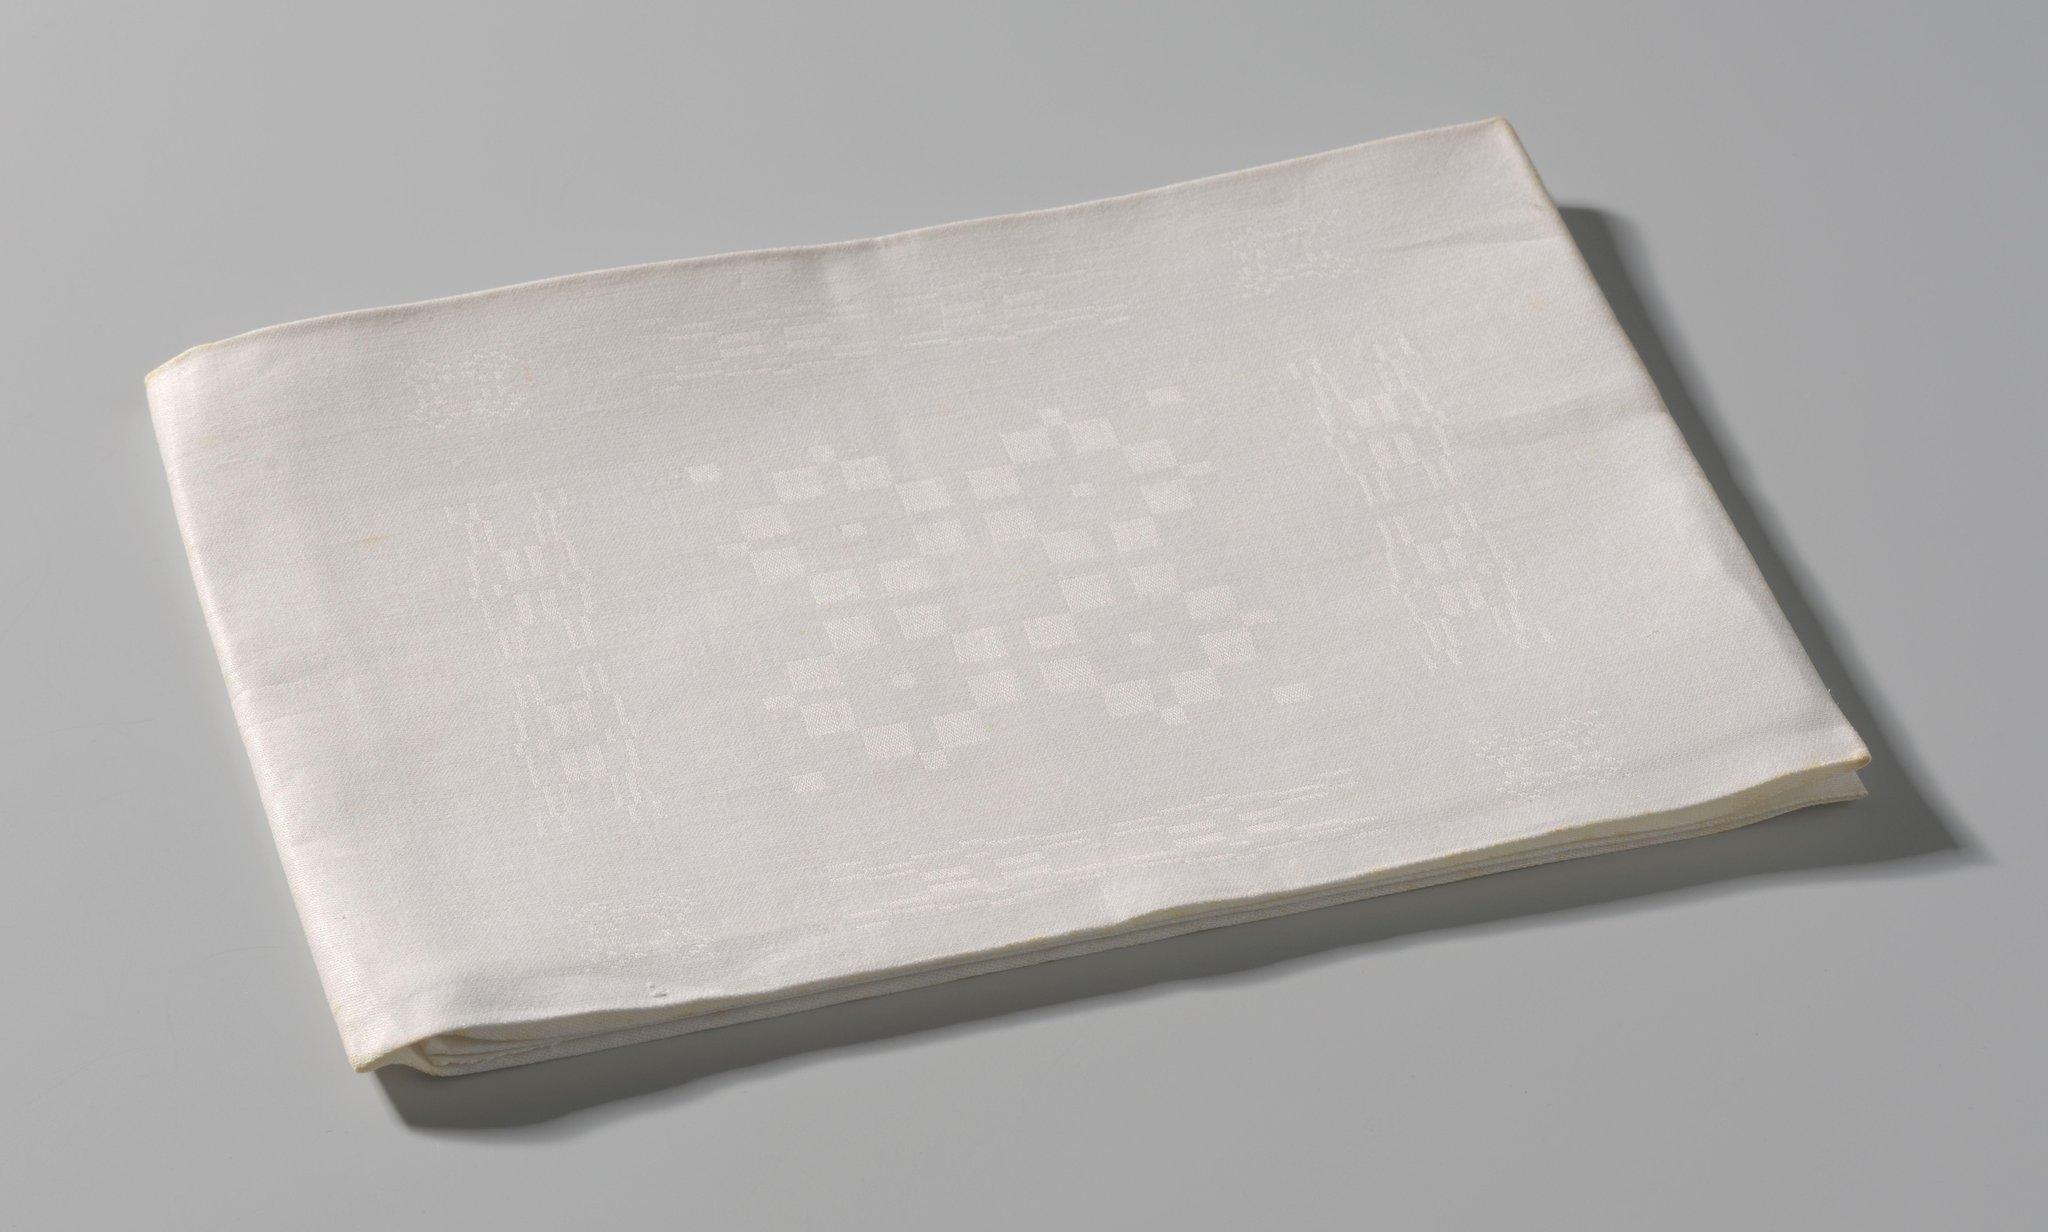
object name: napkin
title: Servet van pellendamast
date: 1800-1900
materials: linen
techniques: cross stitching, weave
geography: north brabant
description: Servet van pellendamast. Het veld is door doorbroken gestreepte lijnen in vierkanten verdeeld, waarbinnen een geblokt patroon. De randen zijn doorbroken gestreept. Het servet is gemerkt in rood met een kruissteek: G100